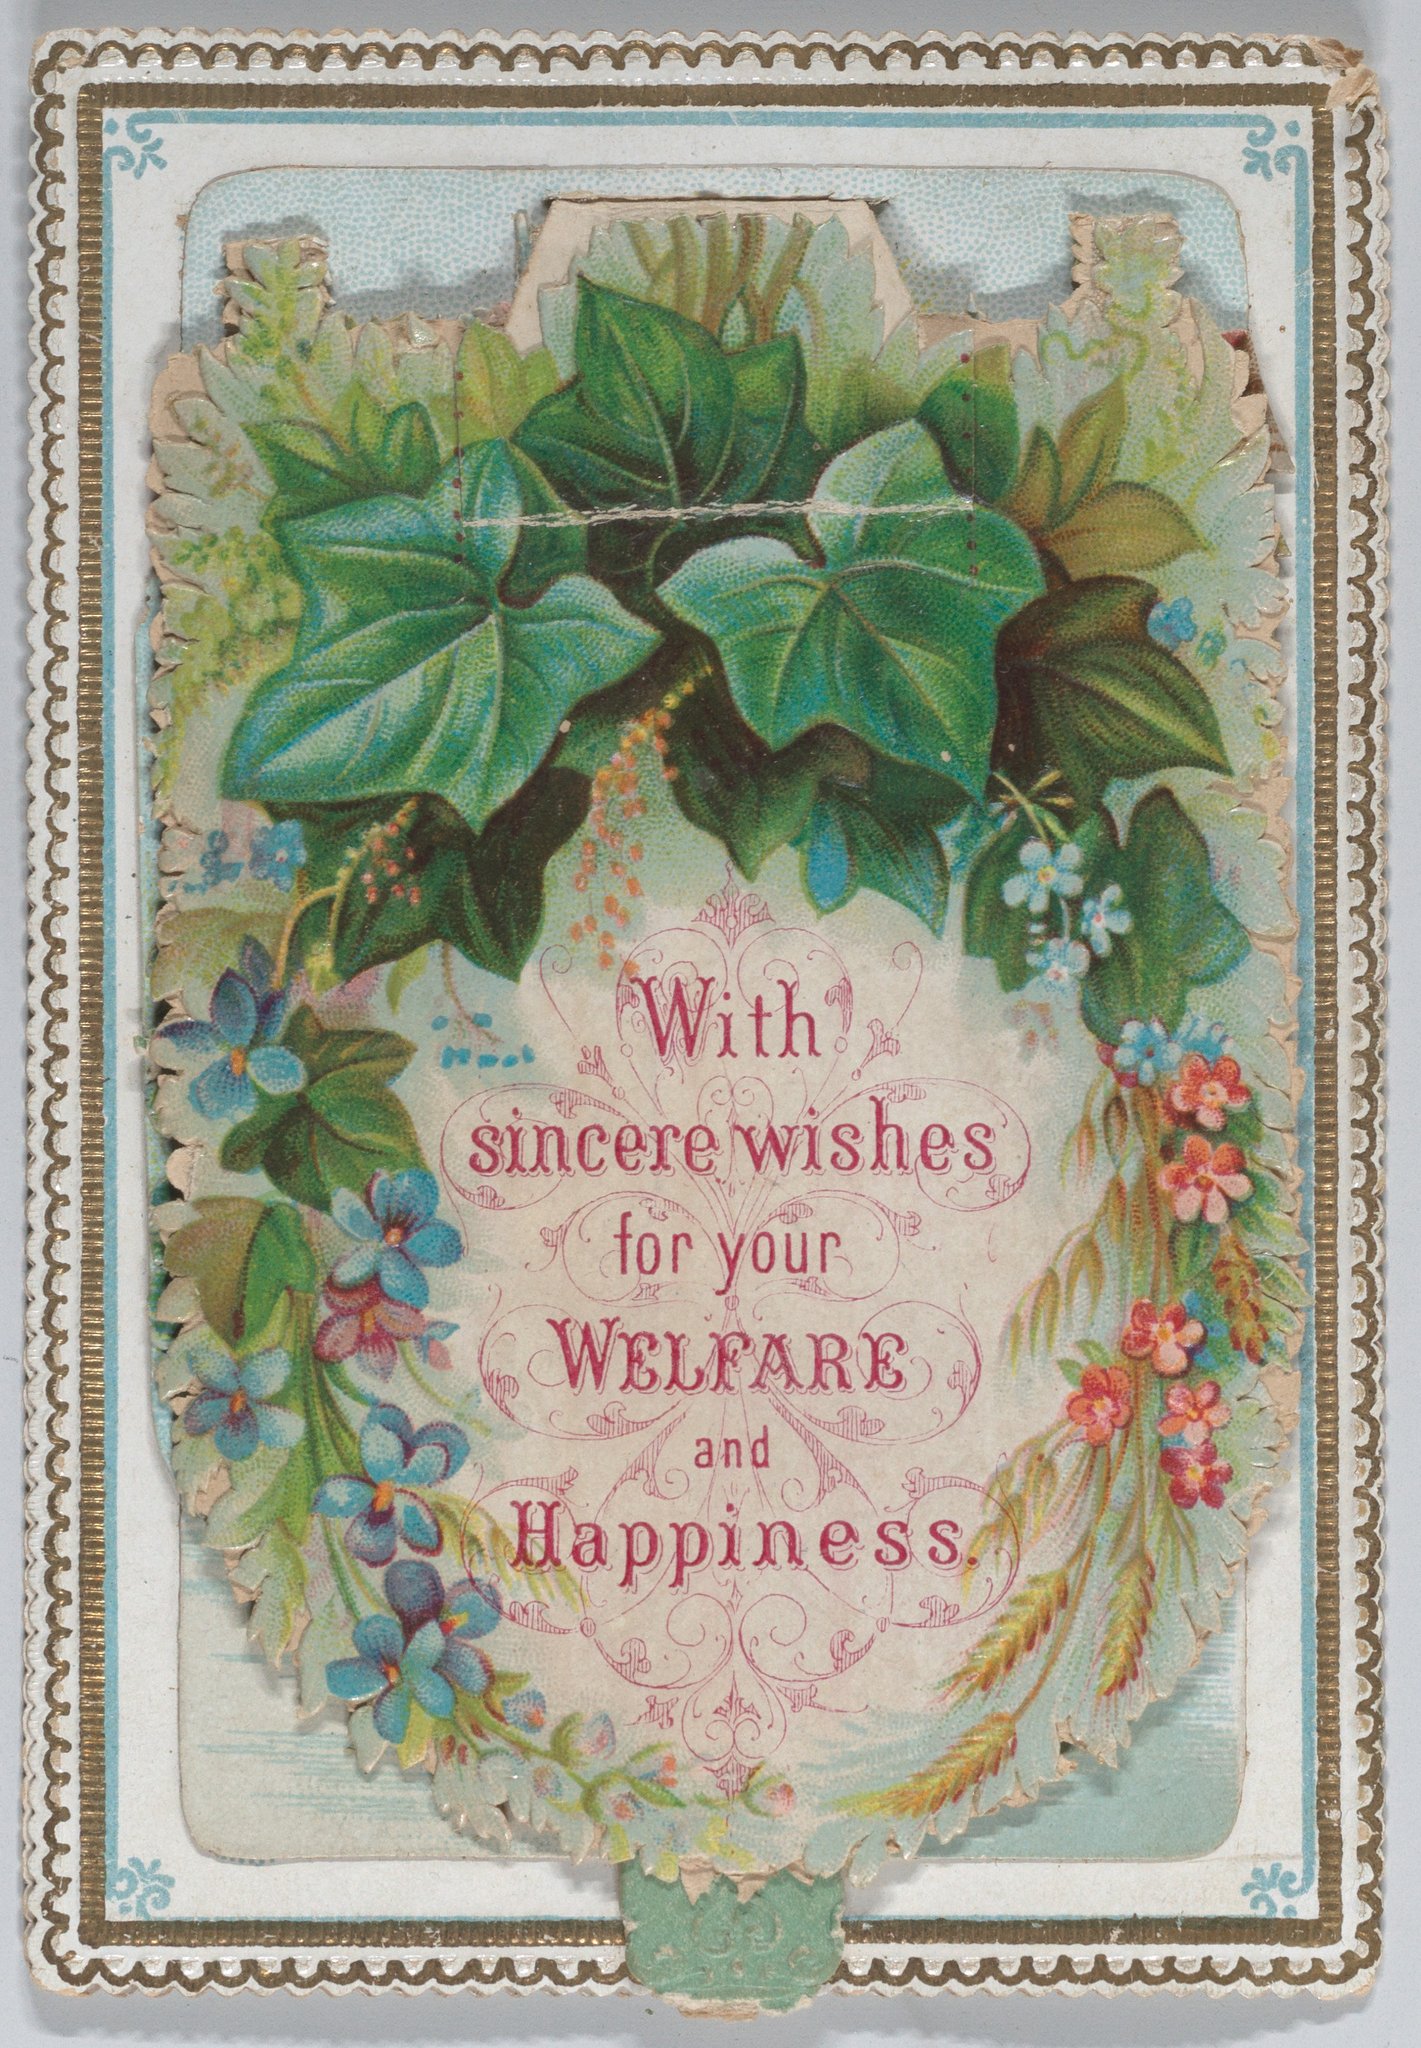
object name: valentine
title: Valentine - Mechanical wreath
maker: anonymous, british, 19th century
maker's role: artist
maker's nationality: british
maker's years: 1800-1900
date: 1875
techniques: chromolithography, cutting